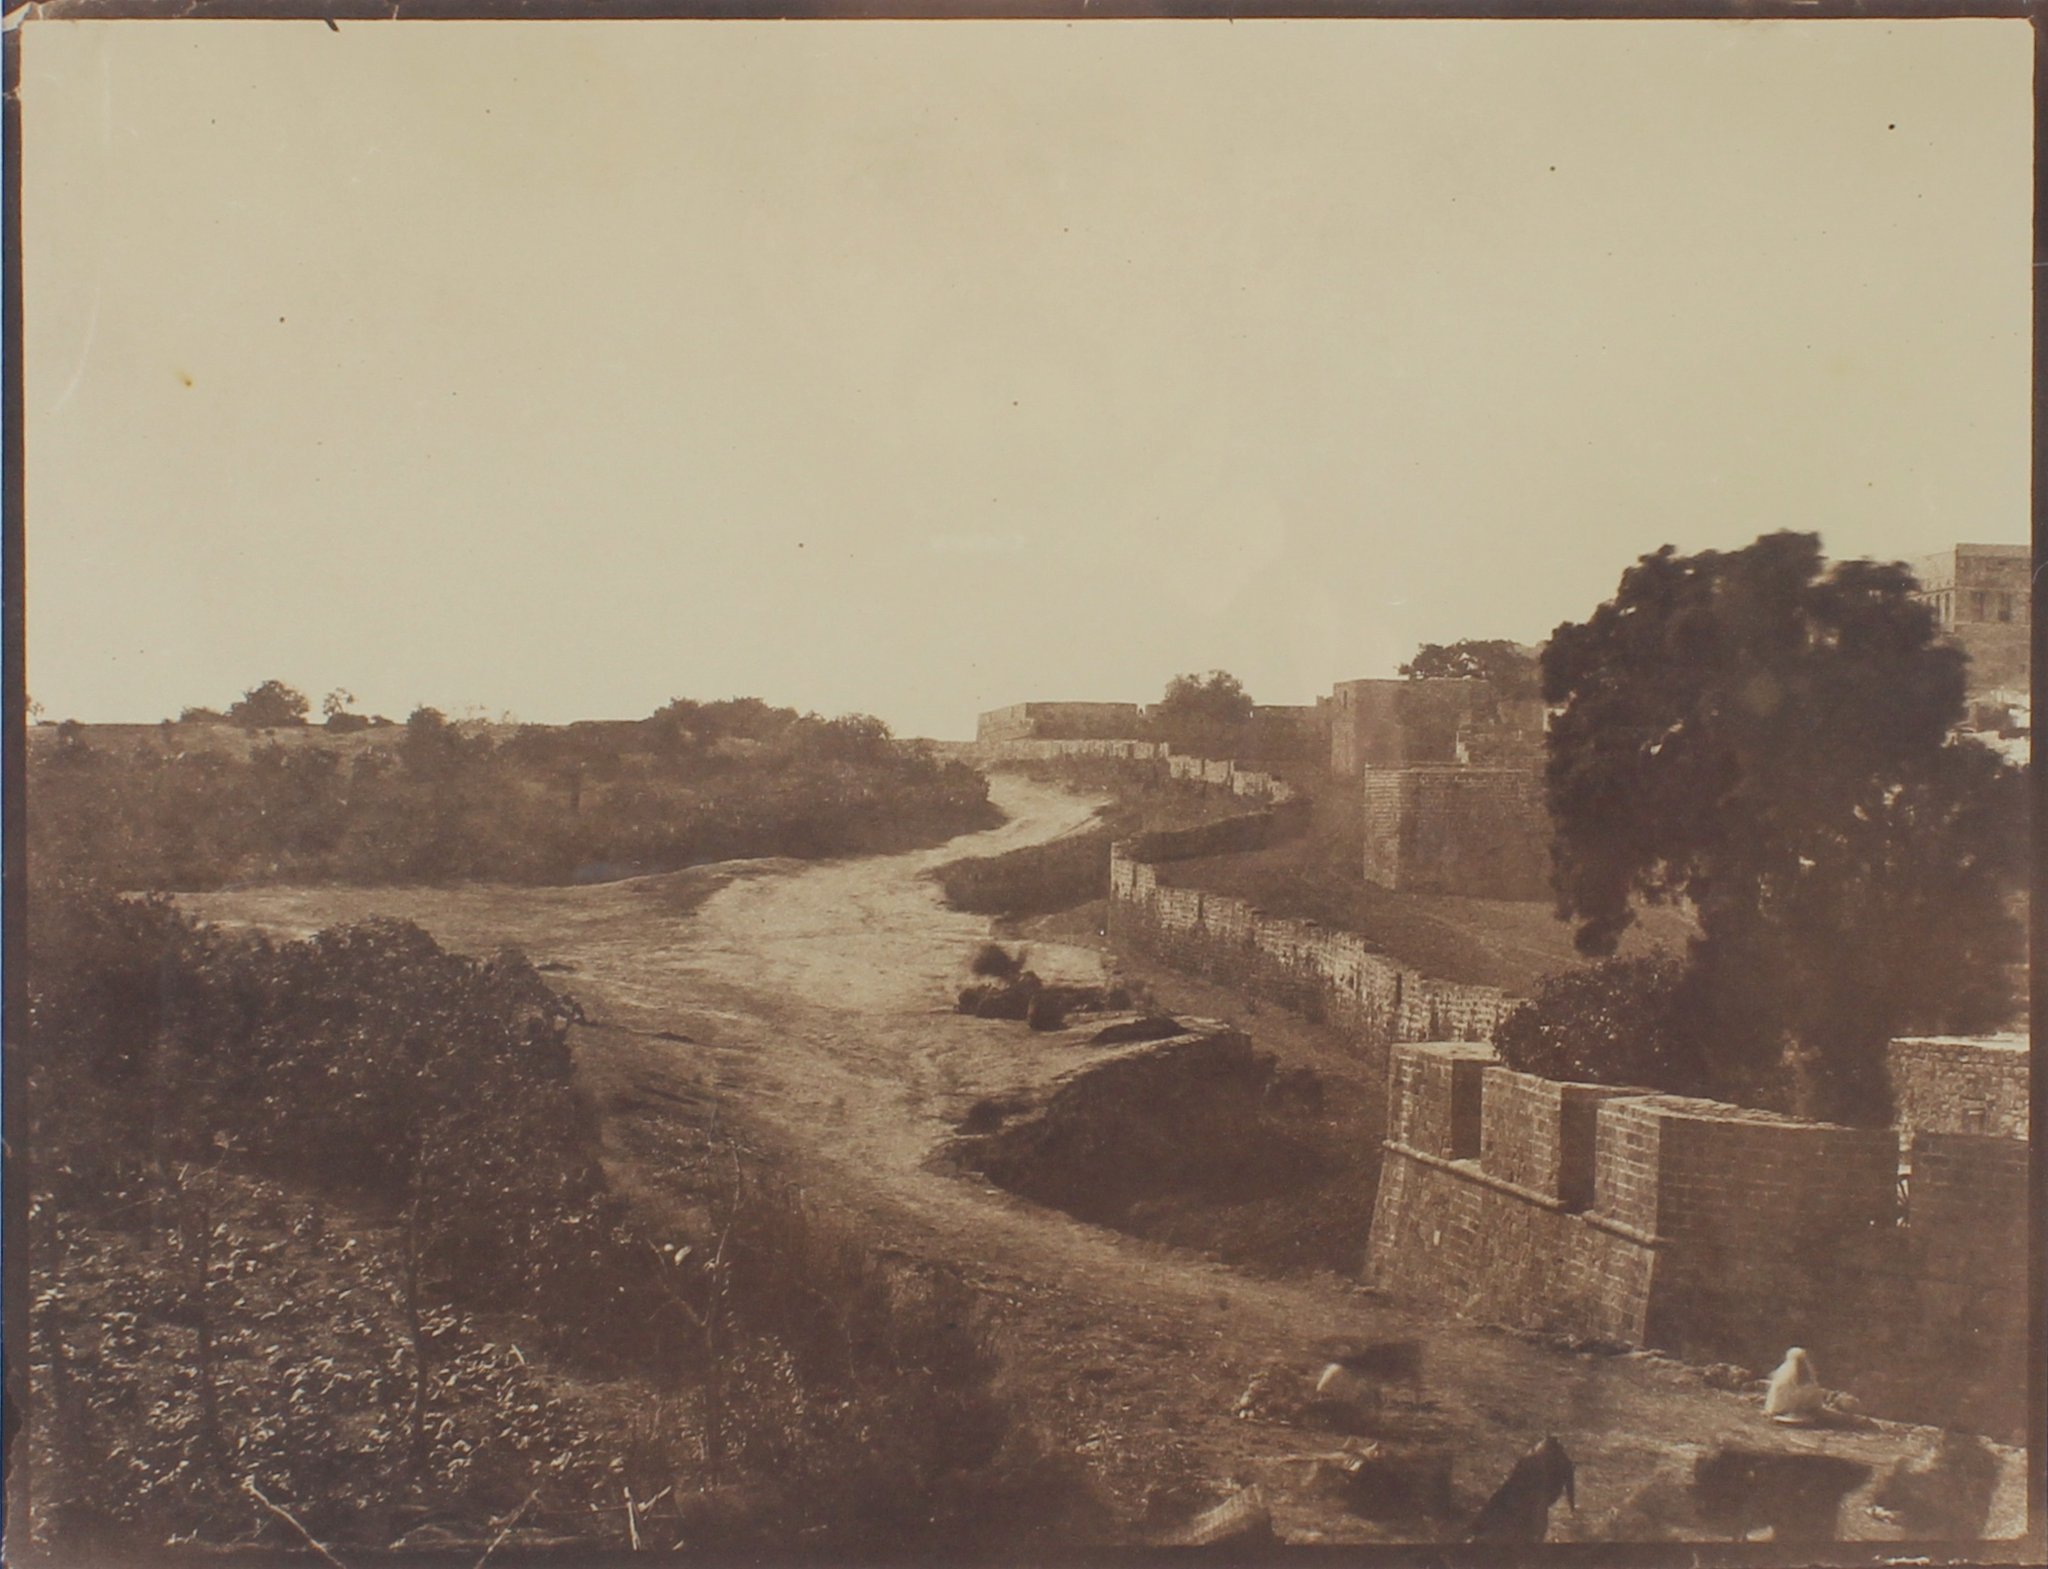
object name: photograph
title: [Walls of Jaffa near the Jerusalem Gate]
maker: louis vignes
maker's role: fotograaf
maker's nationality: french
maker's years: 1831-1896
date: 1860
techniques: paper negative, salted paper print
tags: architecture,landscapes